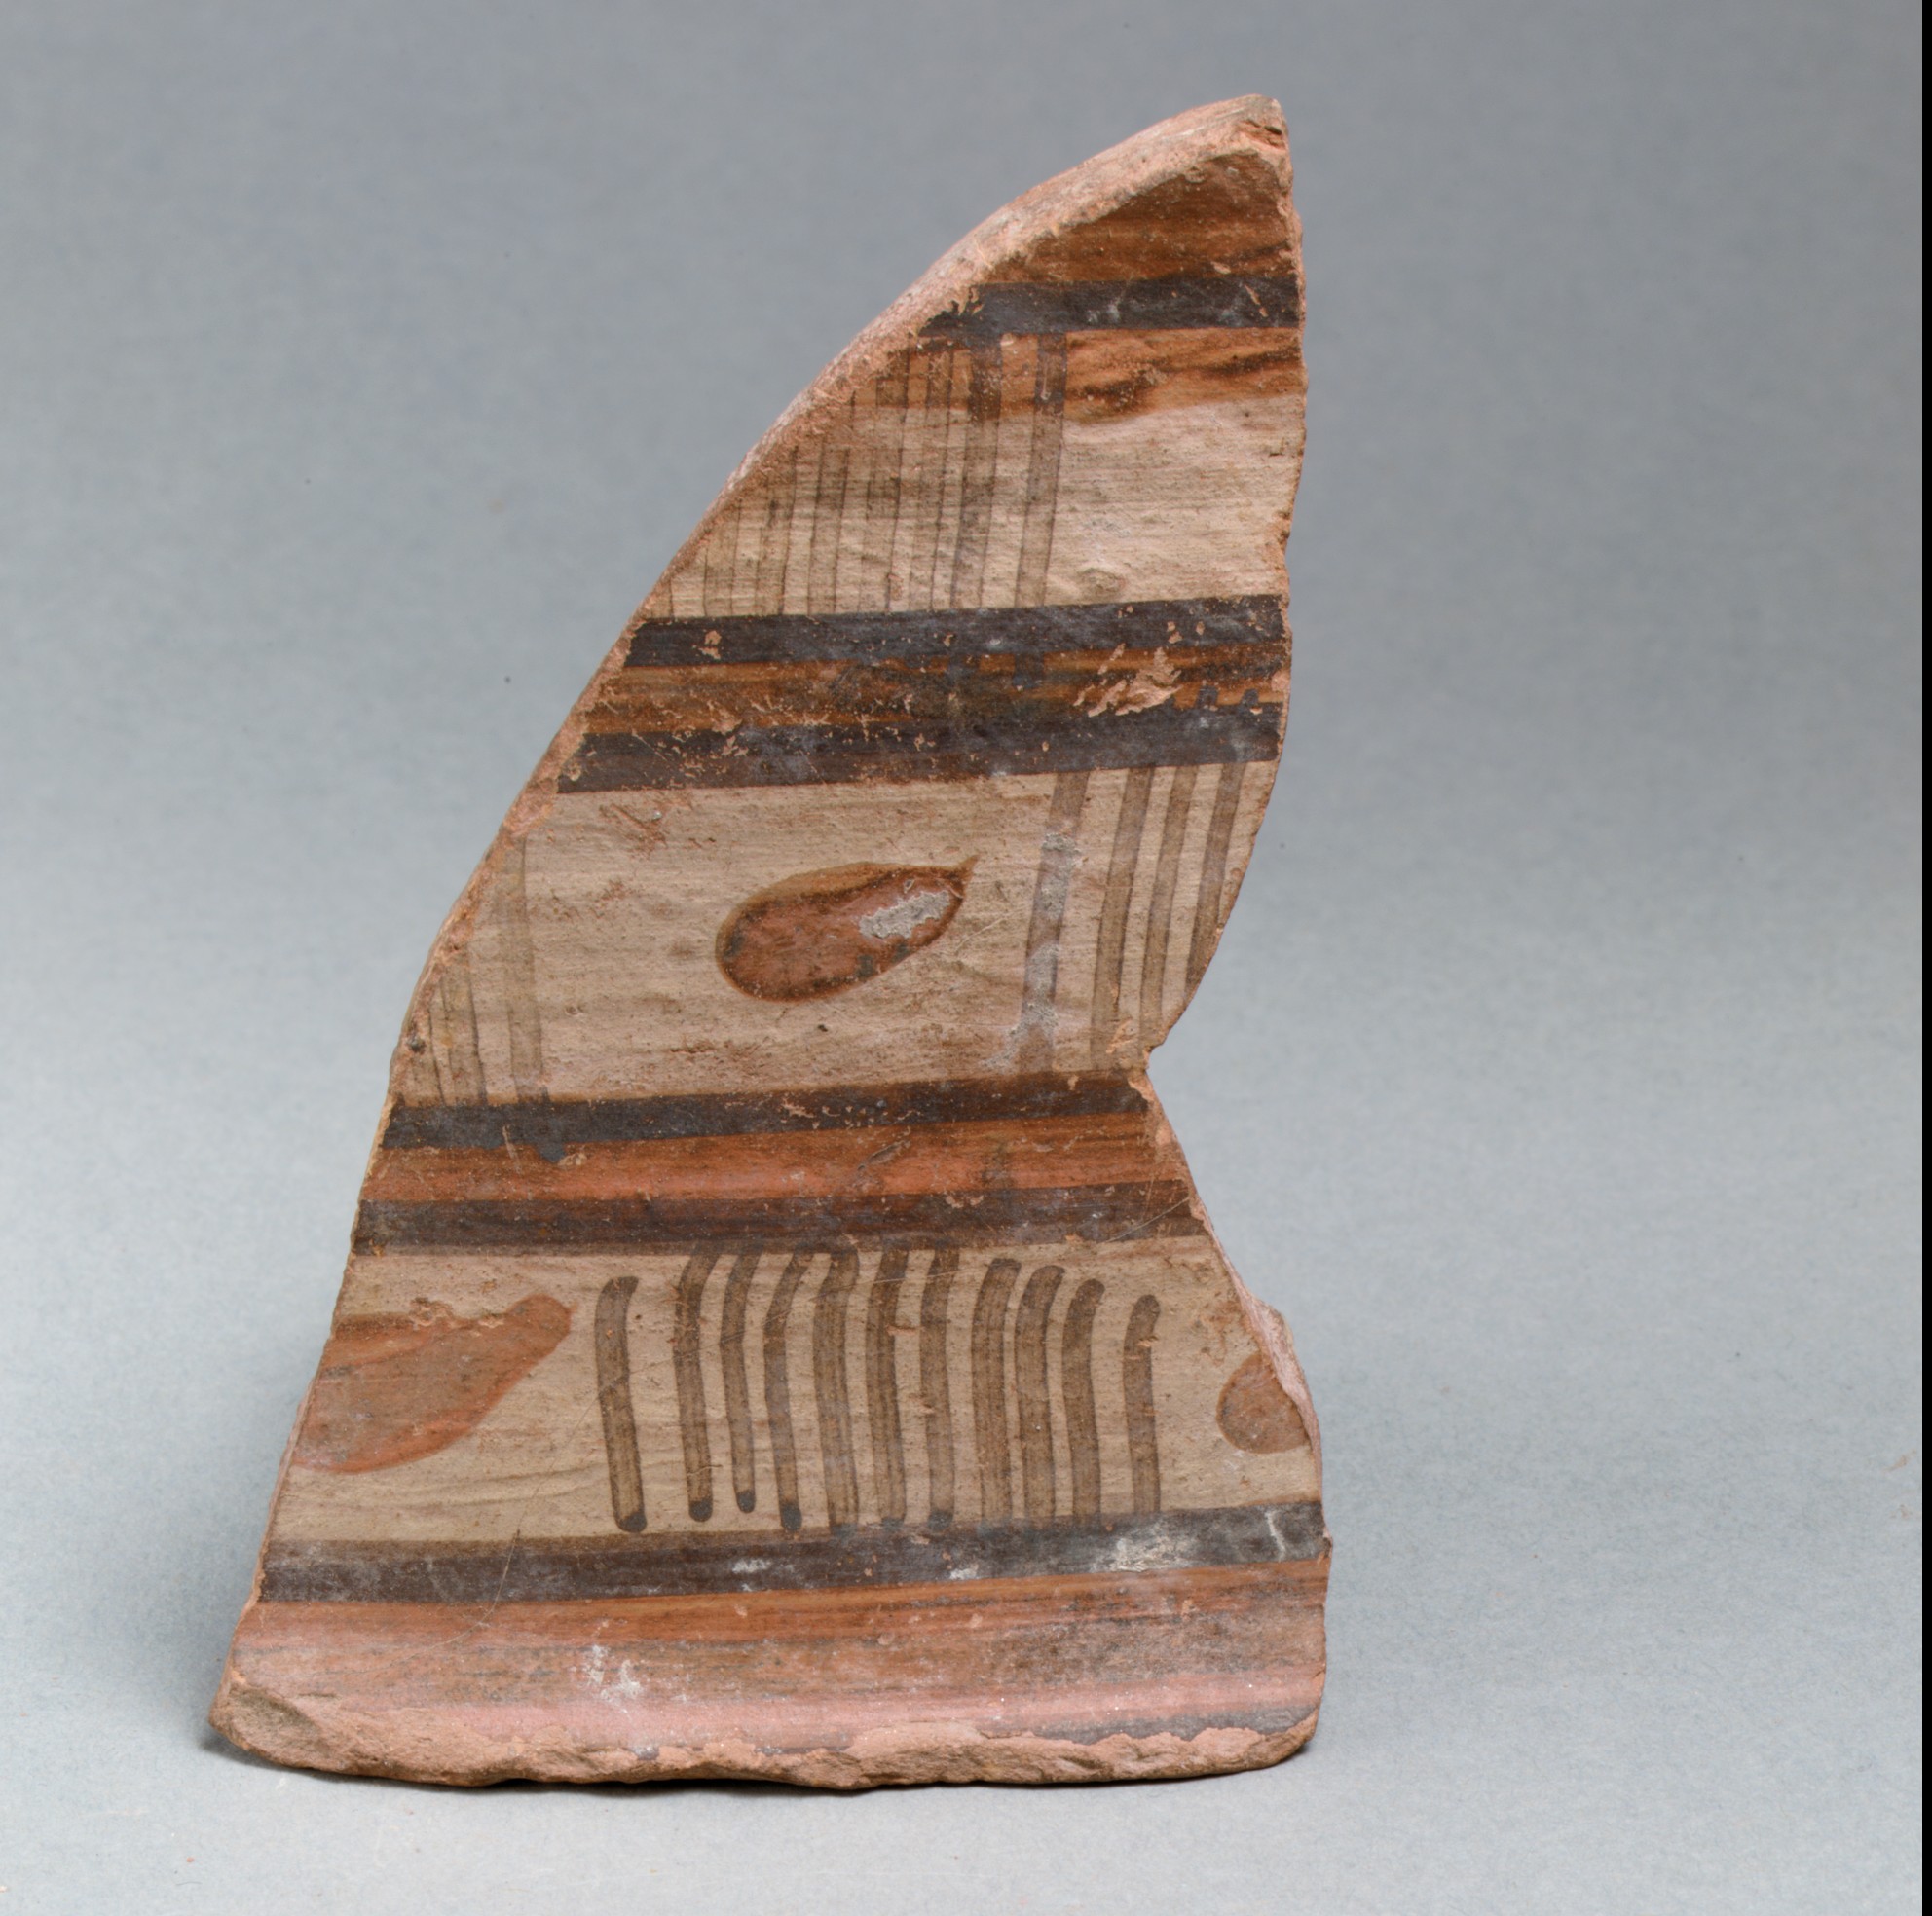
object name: vase fragment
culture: greek or lydian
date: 800-480 BCE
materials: terracotta